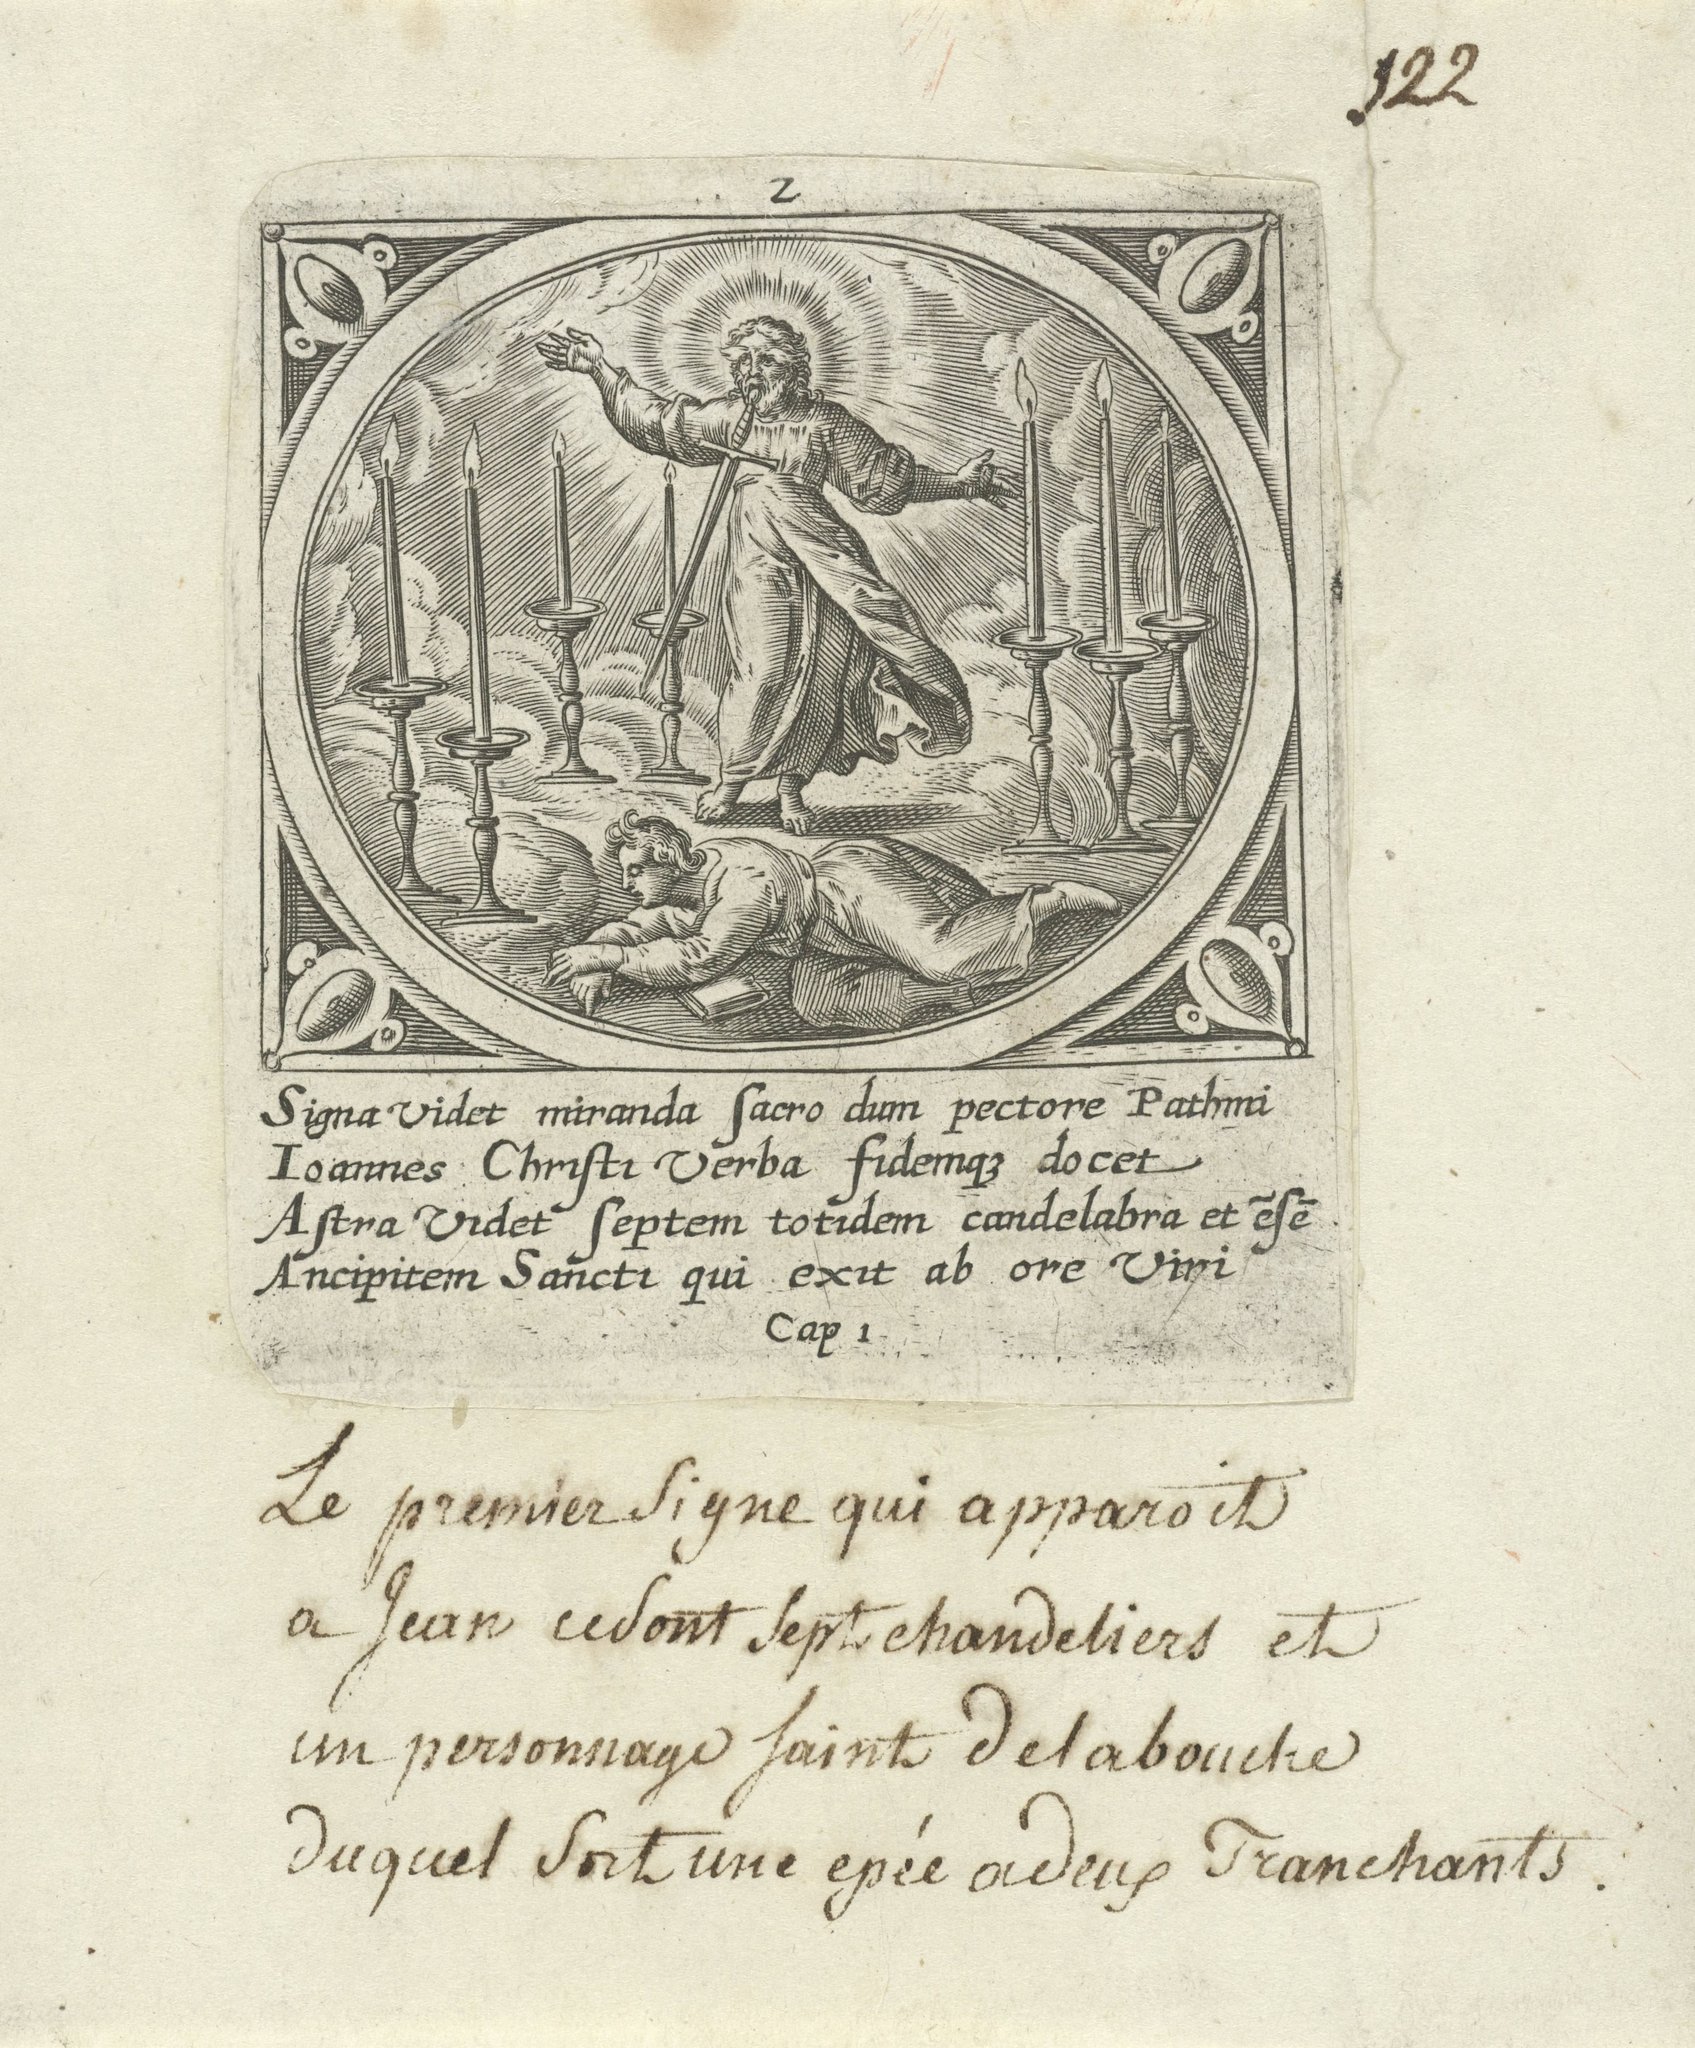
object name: print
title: Icones Revelationum S Johs Evangeliste in Pathmo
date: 1585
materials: paper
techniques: engraving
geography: antwerp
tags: christ between seven golden candlesticks appears to john, who falls to the ground; a sword comes out of christ's mouth and he holds seven stars in his hands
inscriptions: inscription: ‘Le premier [...] Tranchants.’, inscription: ‘122’, collector's mark: Lugt 2228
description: Christus, in de wolken tussen zeven kandelaars, verschijnt aan Johannes. Uit de mond van Christus komt een zwaard. Johannes ligt, met een boek naast zich, op de grond. In de marge een vierregelig onderschrift in het Latijn. Tweede prent uit een serie van vierentwintig met de openbaring van Johannes op Patmos.